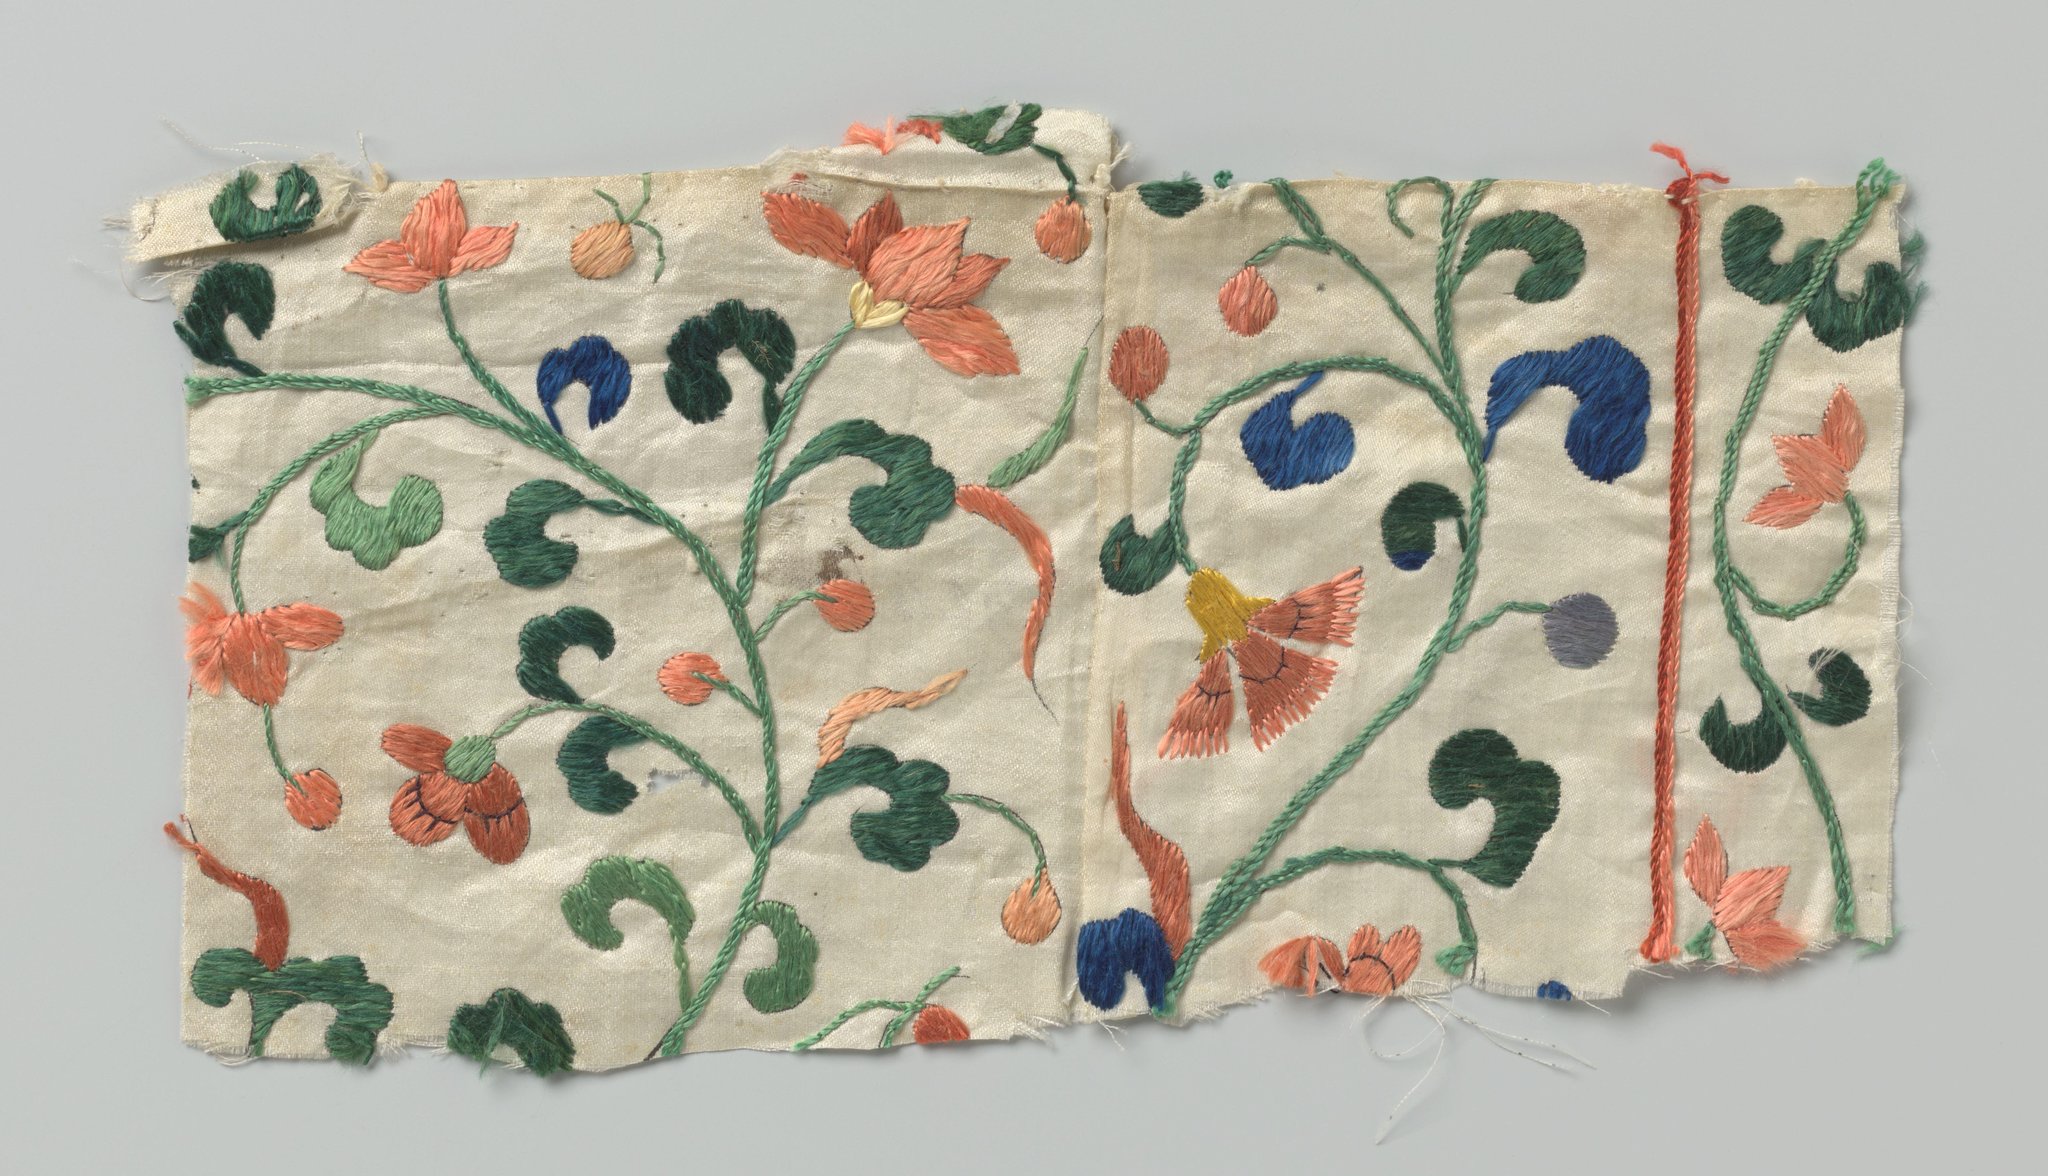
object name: lap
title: Lap van geborduurde zijde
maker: Anonymous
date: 1700-1799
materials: silk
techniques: embroidery stitch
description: Lap van twee aan elkaar gezettte stukken geborduurde zijde, met een patroon van bloemtakken in groen, roze, blauw, geel en grijs.